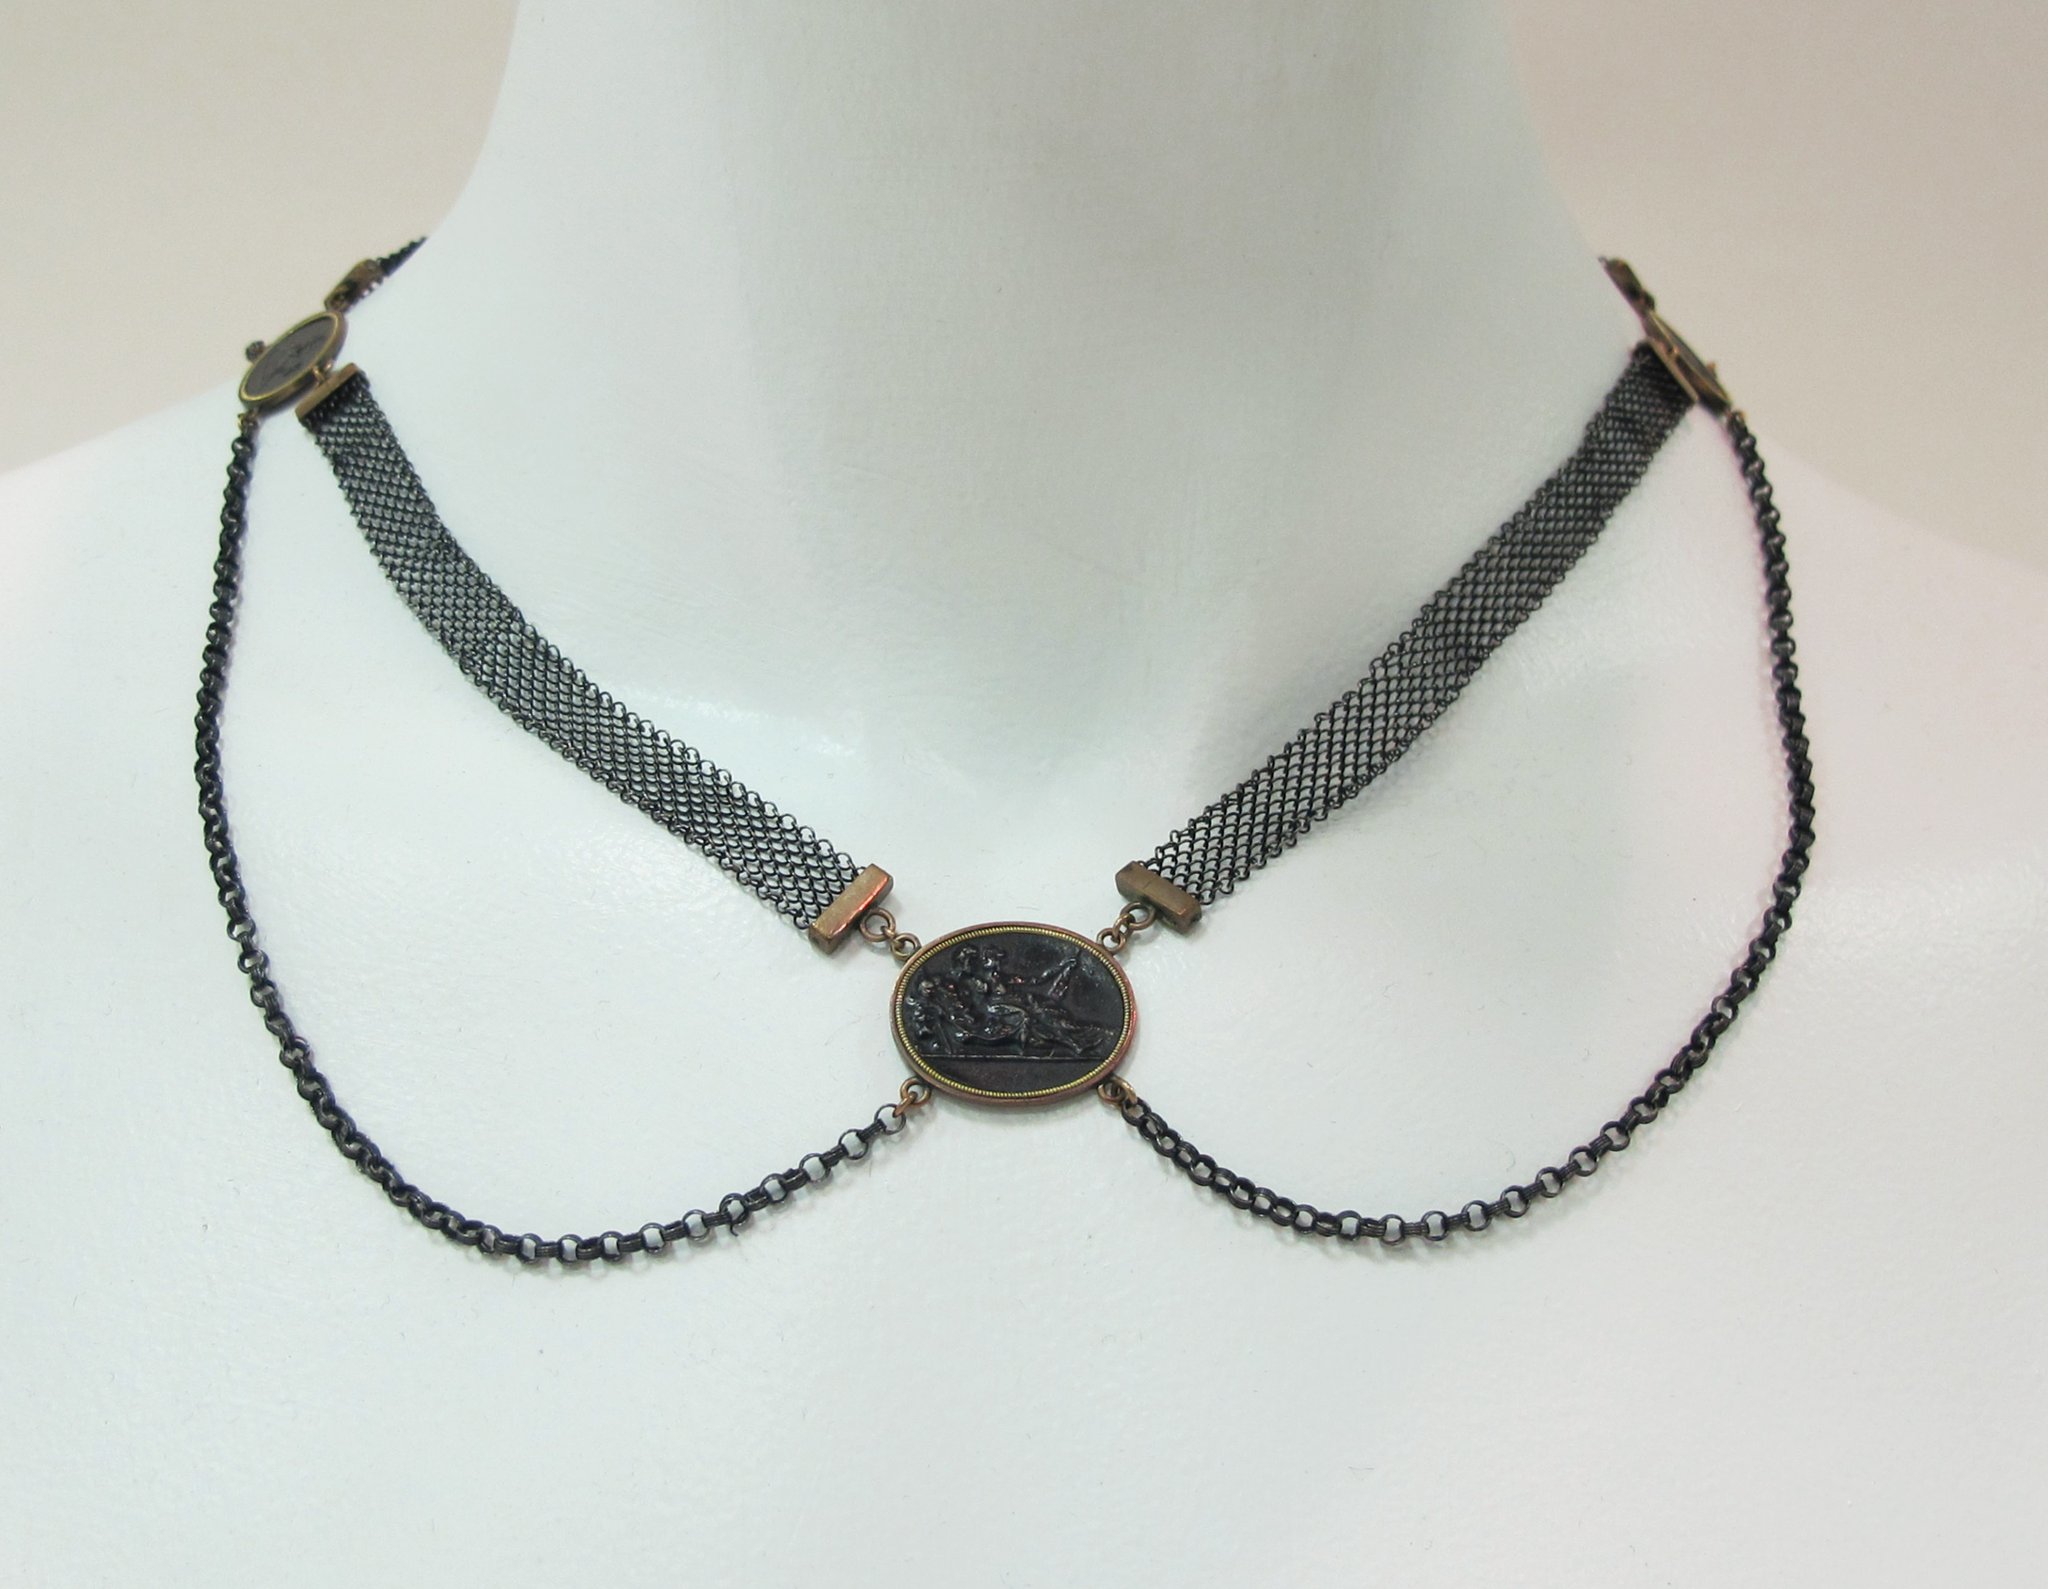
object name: necklace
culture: german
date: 1810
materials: gold, iron